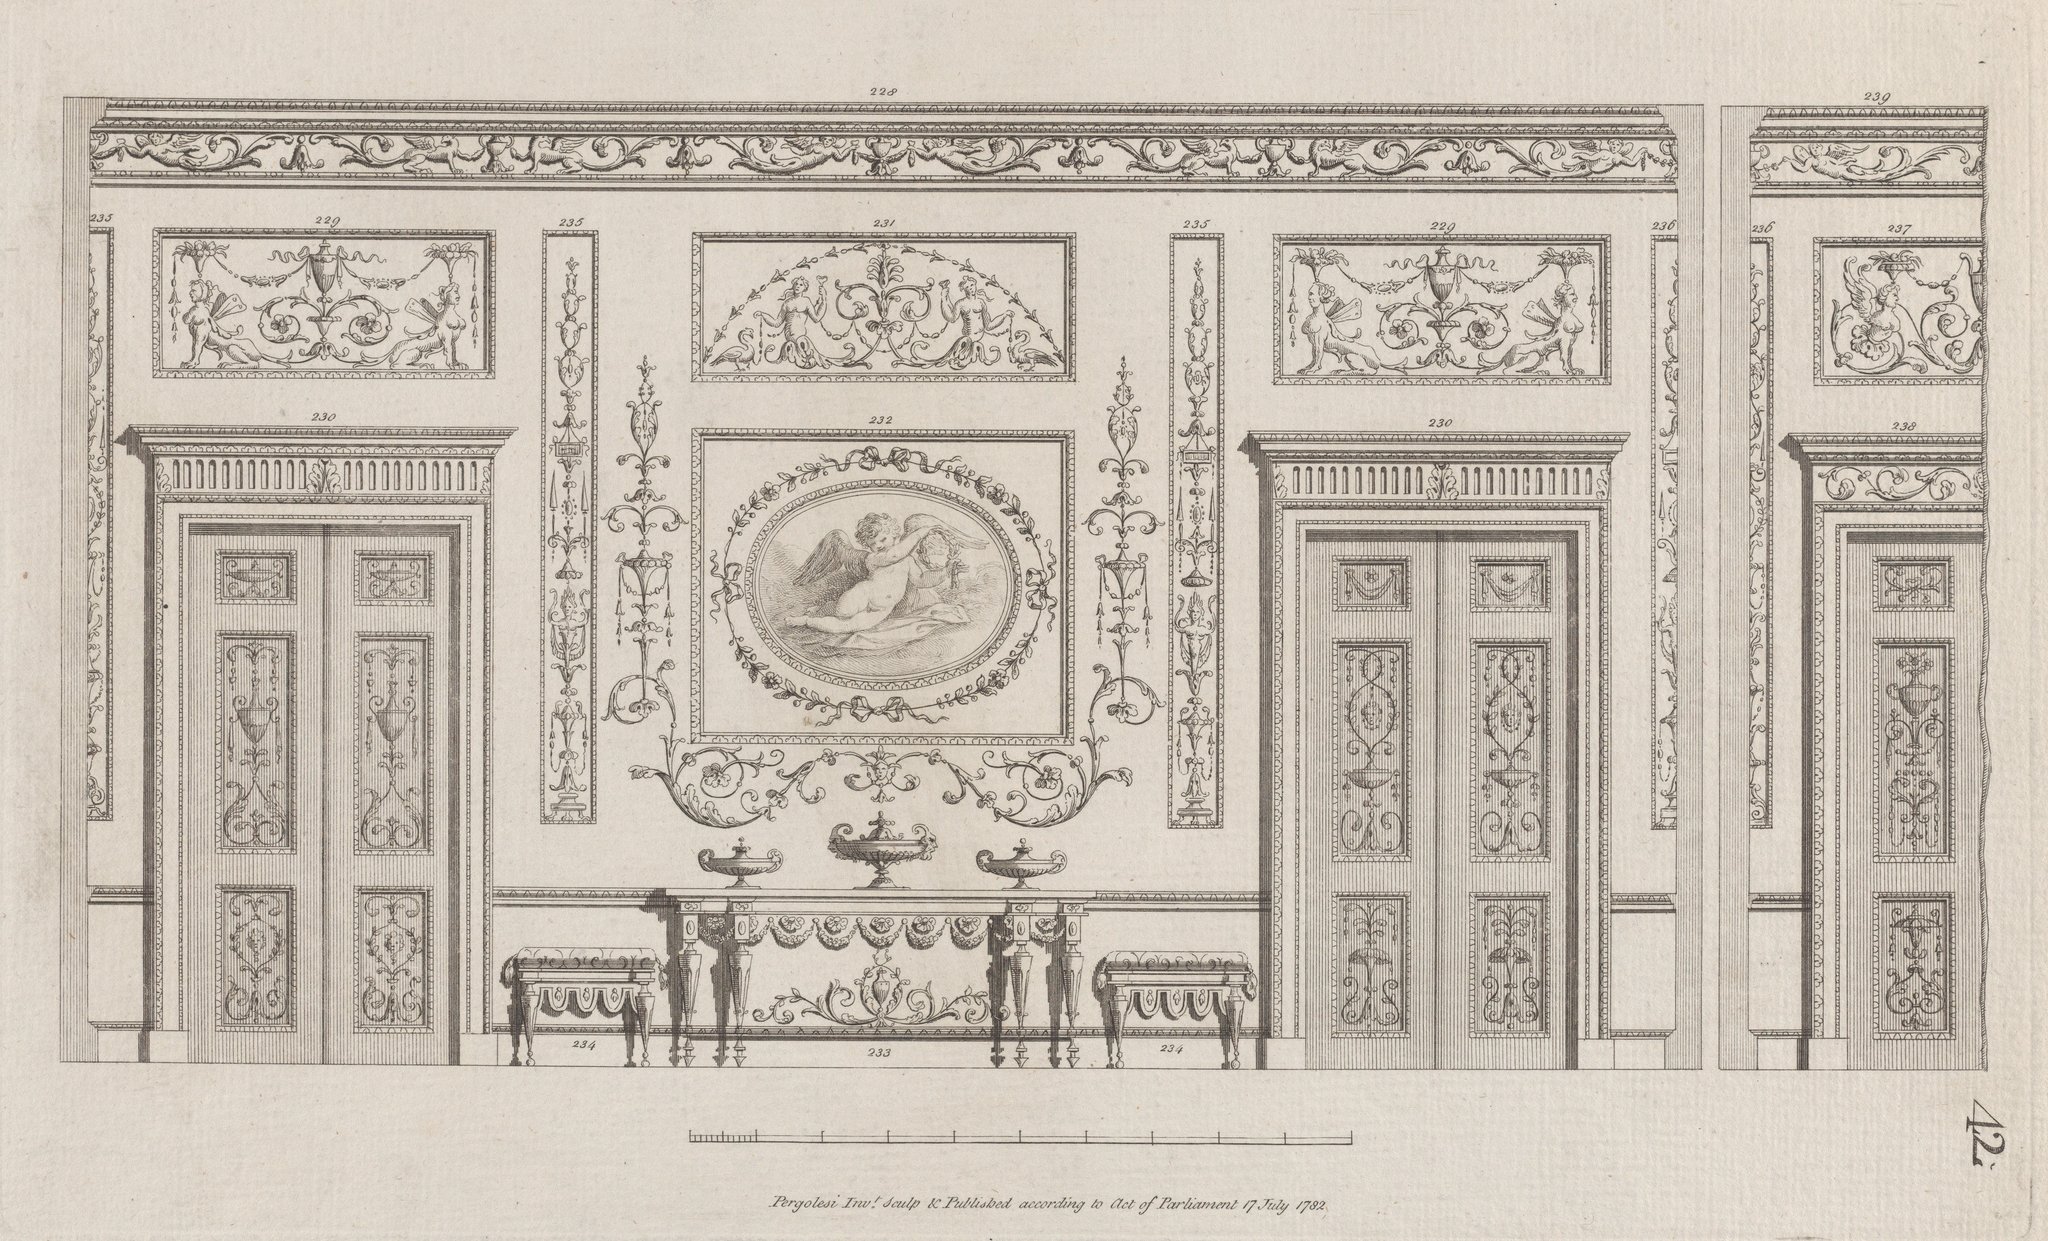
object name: print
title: Interior Ornamented Wall with Doors, nos. 228–239, plate 42 from "Designs for Various Ornaments"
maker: michelangelo pergolesi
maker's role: artist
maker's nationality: italian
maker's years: 1760-1801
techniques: etching